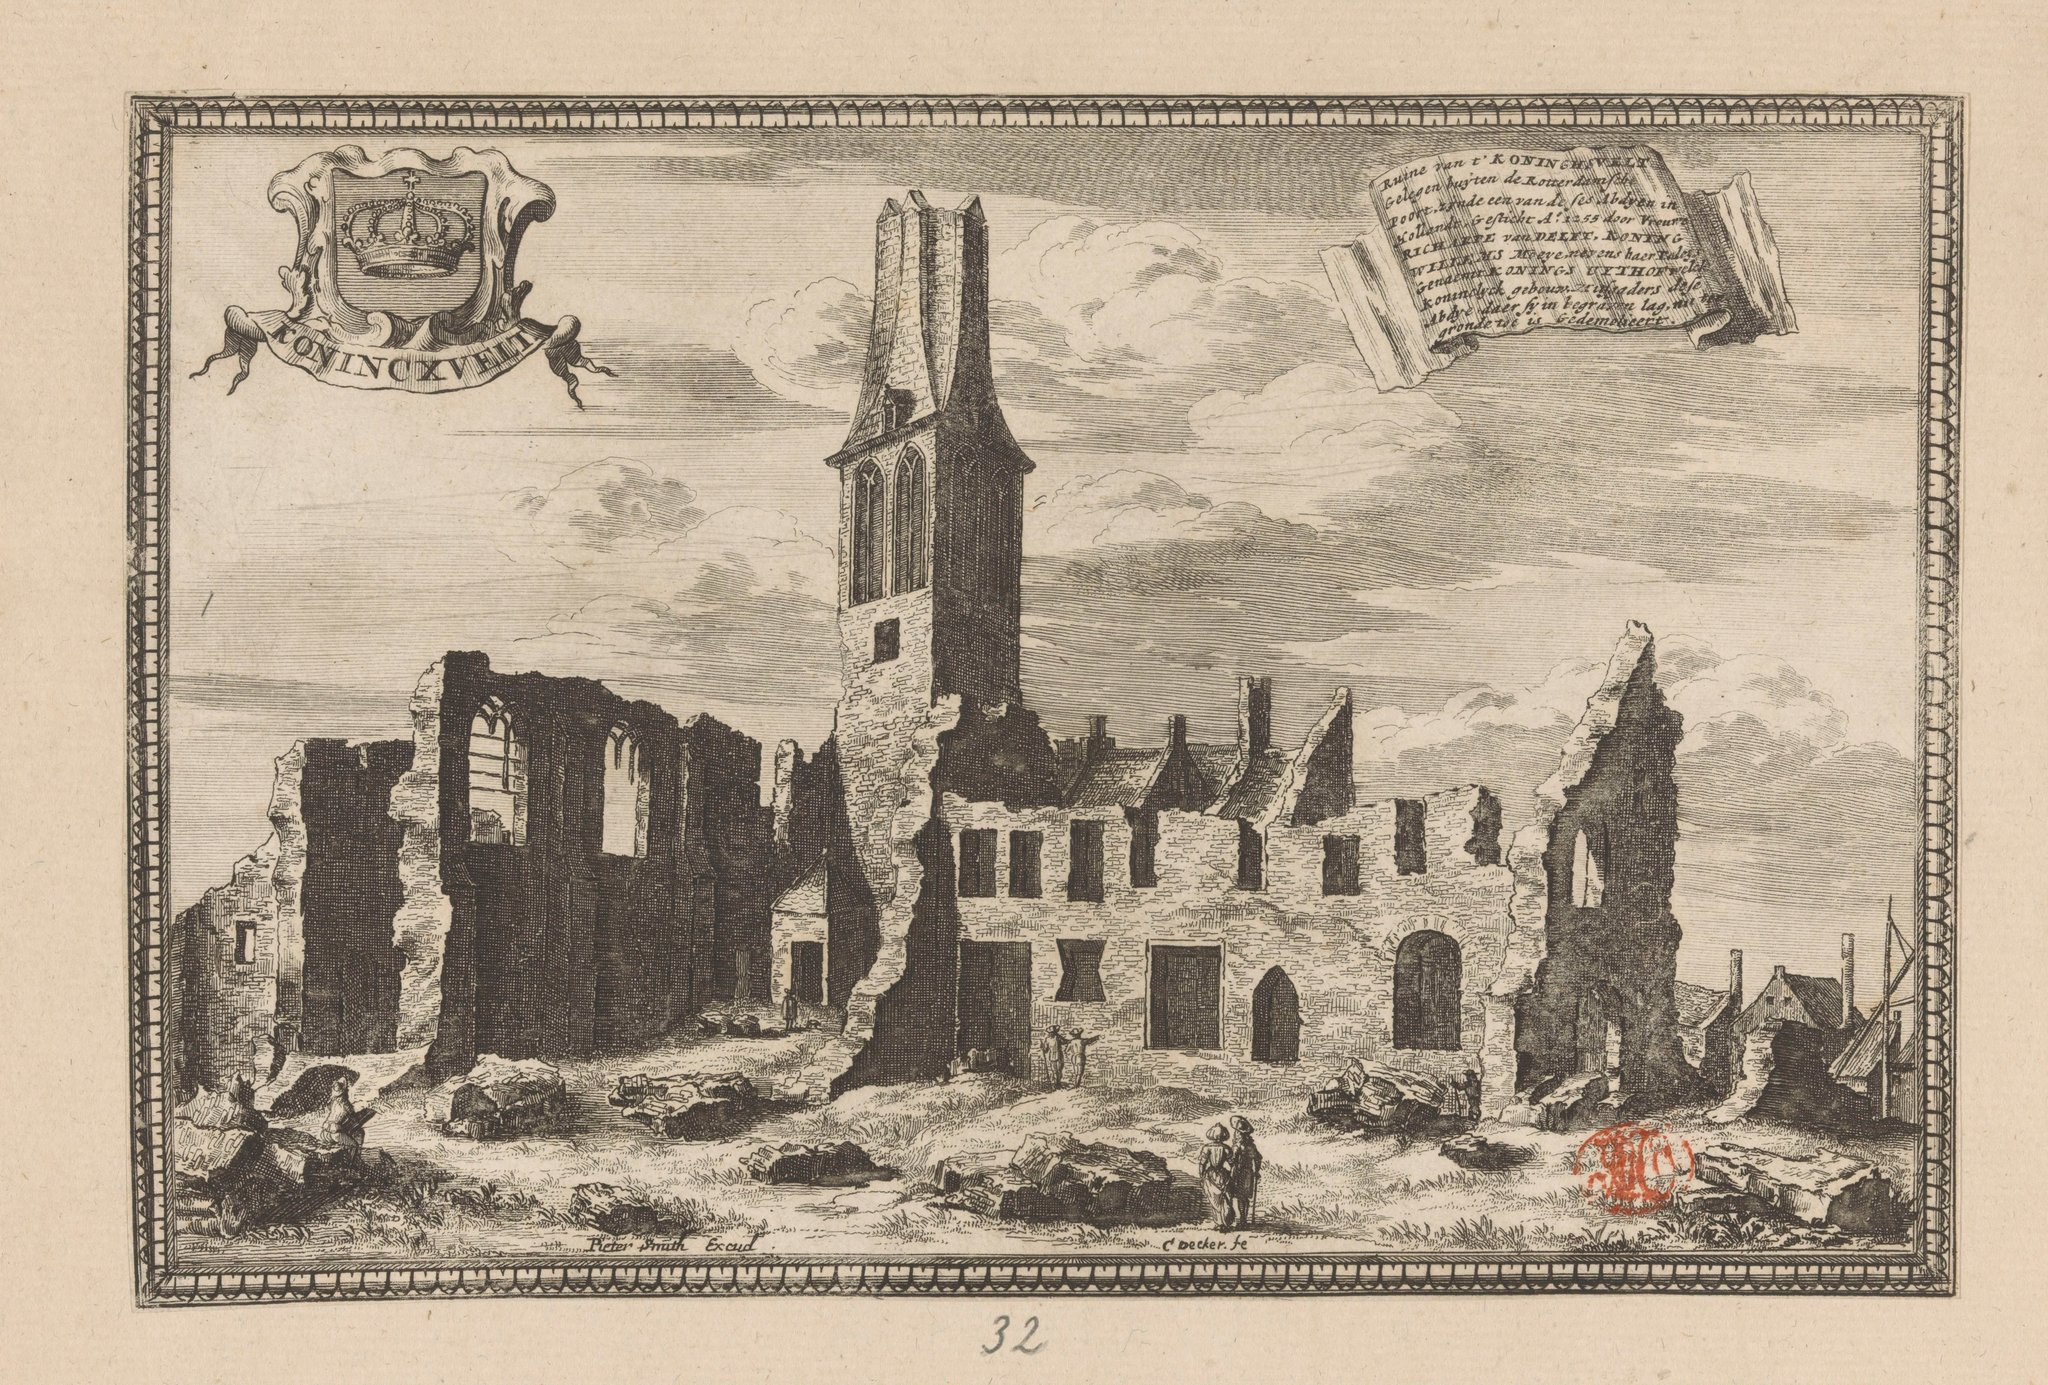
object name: print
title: Konincxvelt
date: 1680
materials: paper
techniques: etching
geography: netherlands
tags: abbey, monastery, convent ~ roman catholic church, ruin of church, monastery, etc.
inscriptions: collector's mark: Lugt 195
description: Prent ook gebruikt in: Bleyswijck, Dirk Evertsz. Beschryvinge der stadt Delft, betreffende des selfs situatie, oorsprong en ouderdom, opkomst en voortgangh (…). Delft: Arnold Bon, 1667 (prenten vanaf 1680 ingebonden), p. 348. Hoewel deze publicatie al in 1667 werd uitgegeven, zijn de bijhorende prenten pas in 1680, tegelijkertijd met het tweede deel ('Vervolg van de beschryvinge der stadt Delft'), verschenen. In het tweede deel zat een bijlage waarin beschreven staat welke prenten waar in het eerste en tweede deel ingebonden dienden te worden. Zodoende zijn de prenten uit het eerste deel dus pas in of na 1680 ingebonden. Hierdoor wordt vaak gedacht dat de prenten uit het eerste deel dateren uit 1667, hetgeen niet klopt. De prenten werden geleverd door drukker/uitgever Pieter Smith.